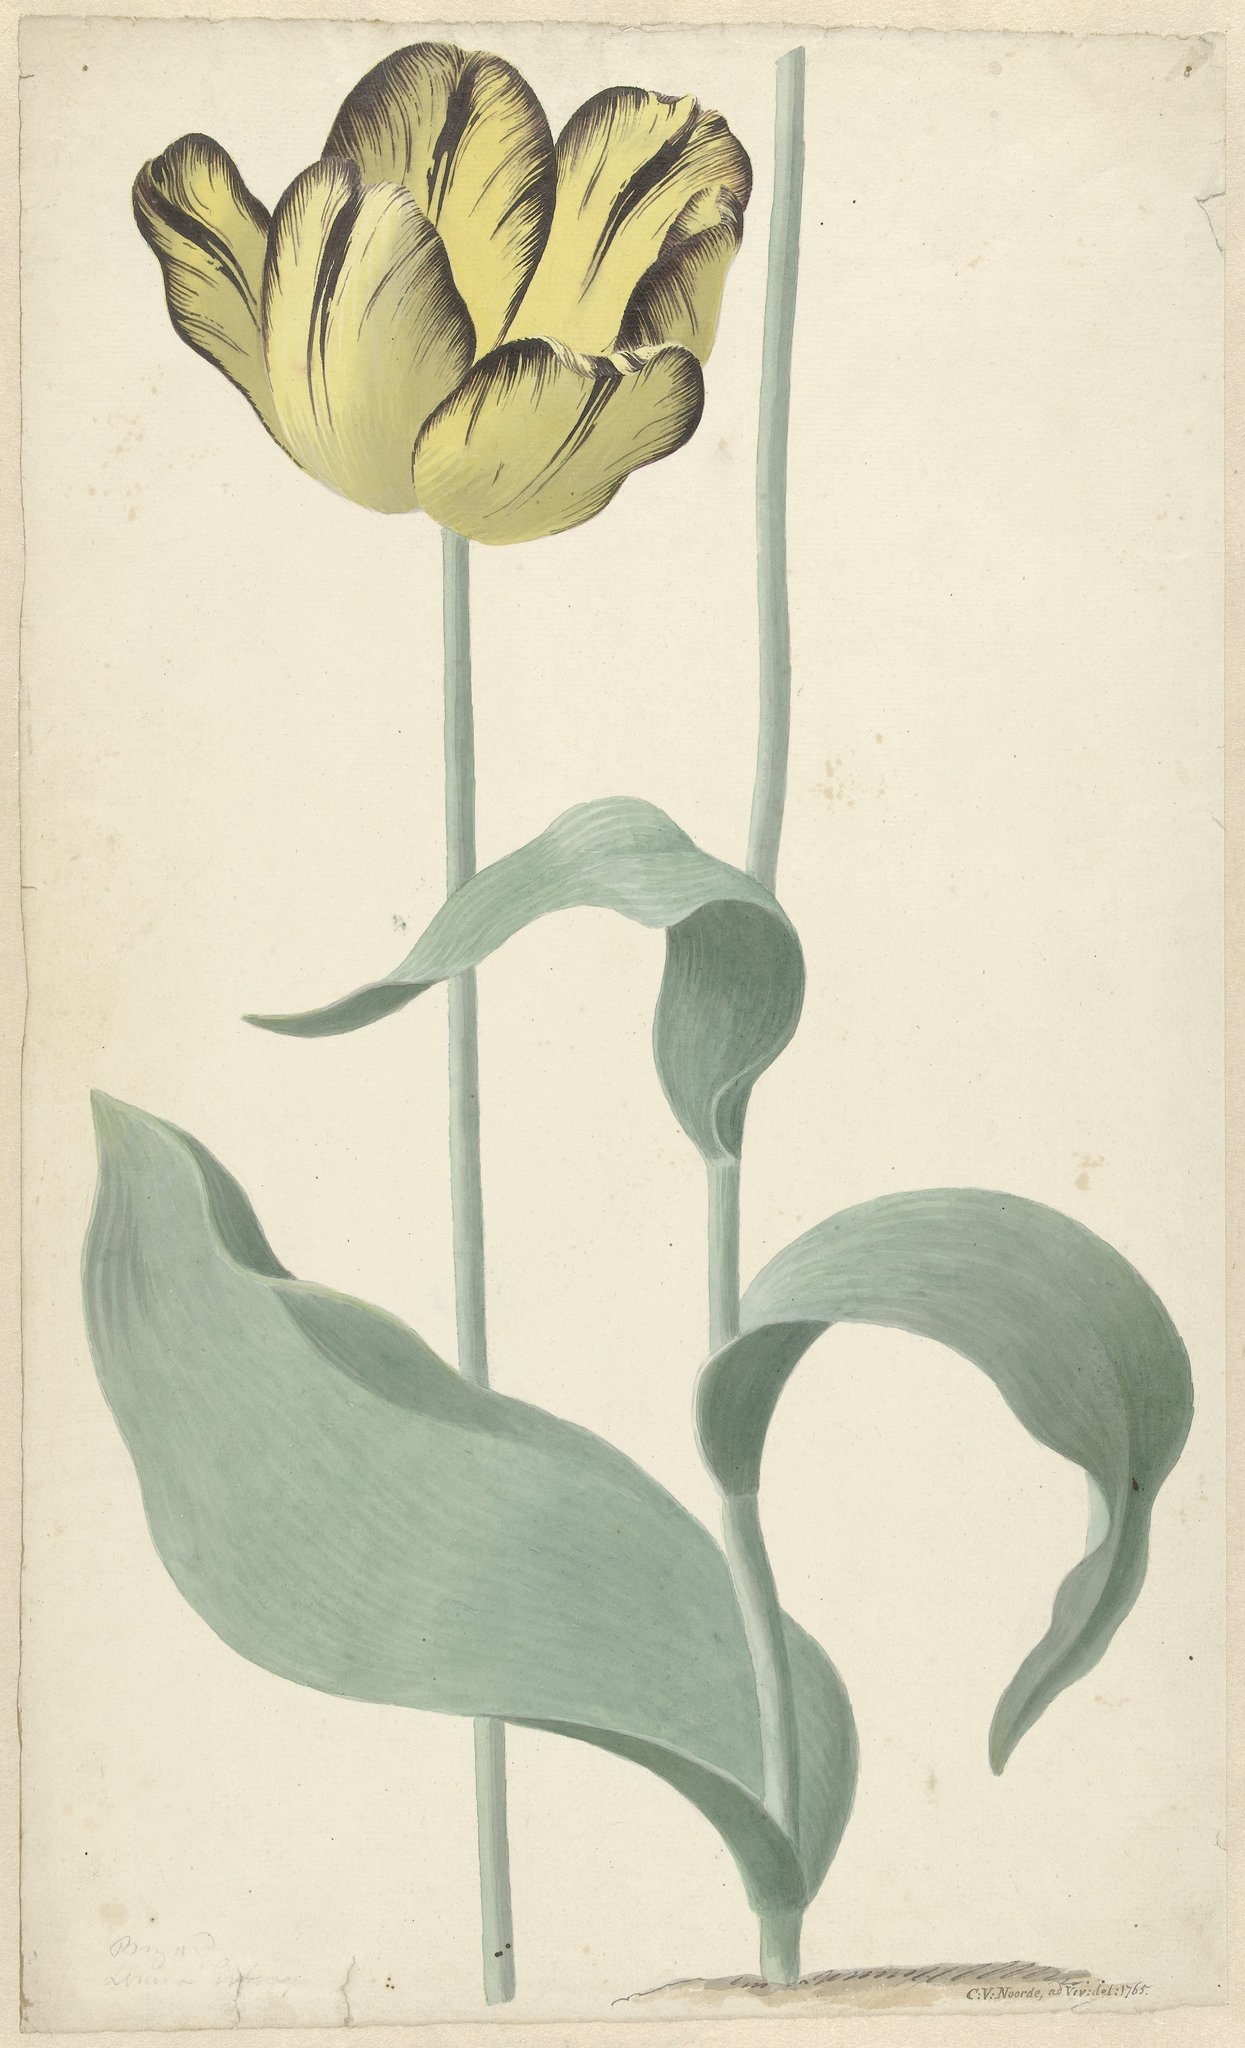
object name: drawing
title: Bizard Louis d'Effroy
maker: cornelis van noorde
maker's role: draughtsman, print maker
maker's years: 1731-1795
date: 1765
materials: paper, pencil, watercolor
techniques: brush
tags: flowers: tulip